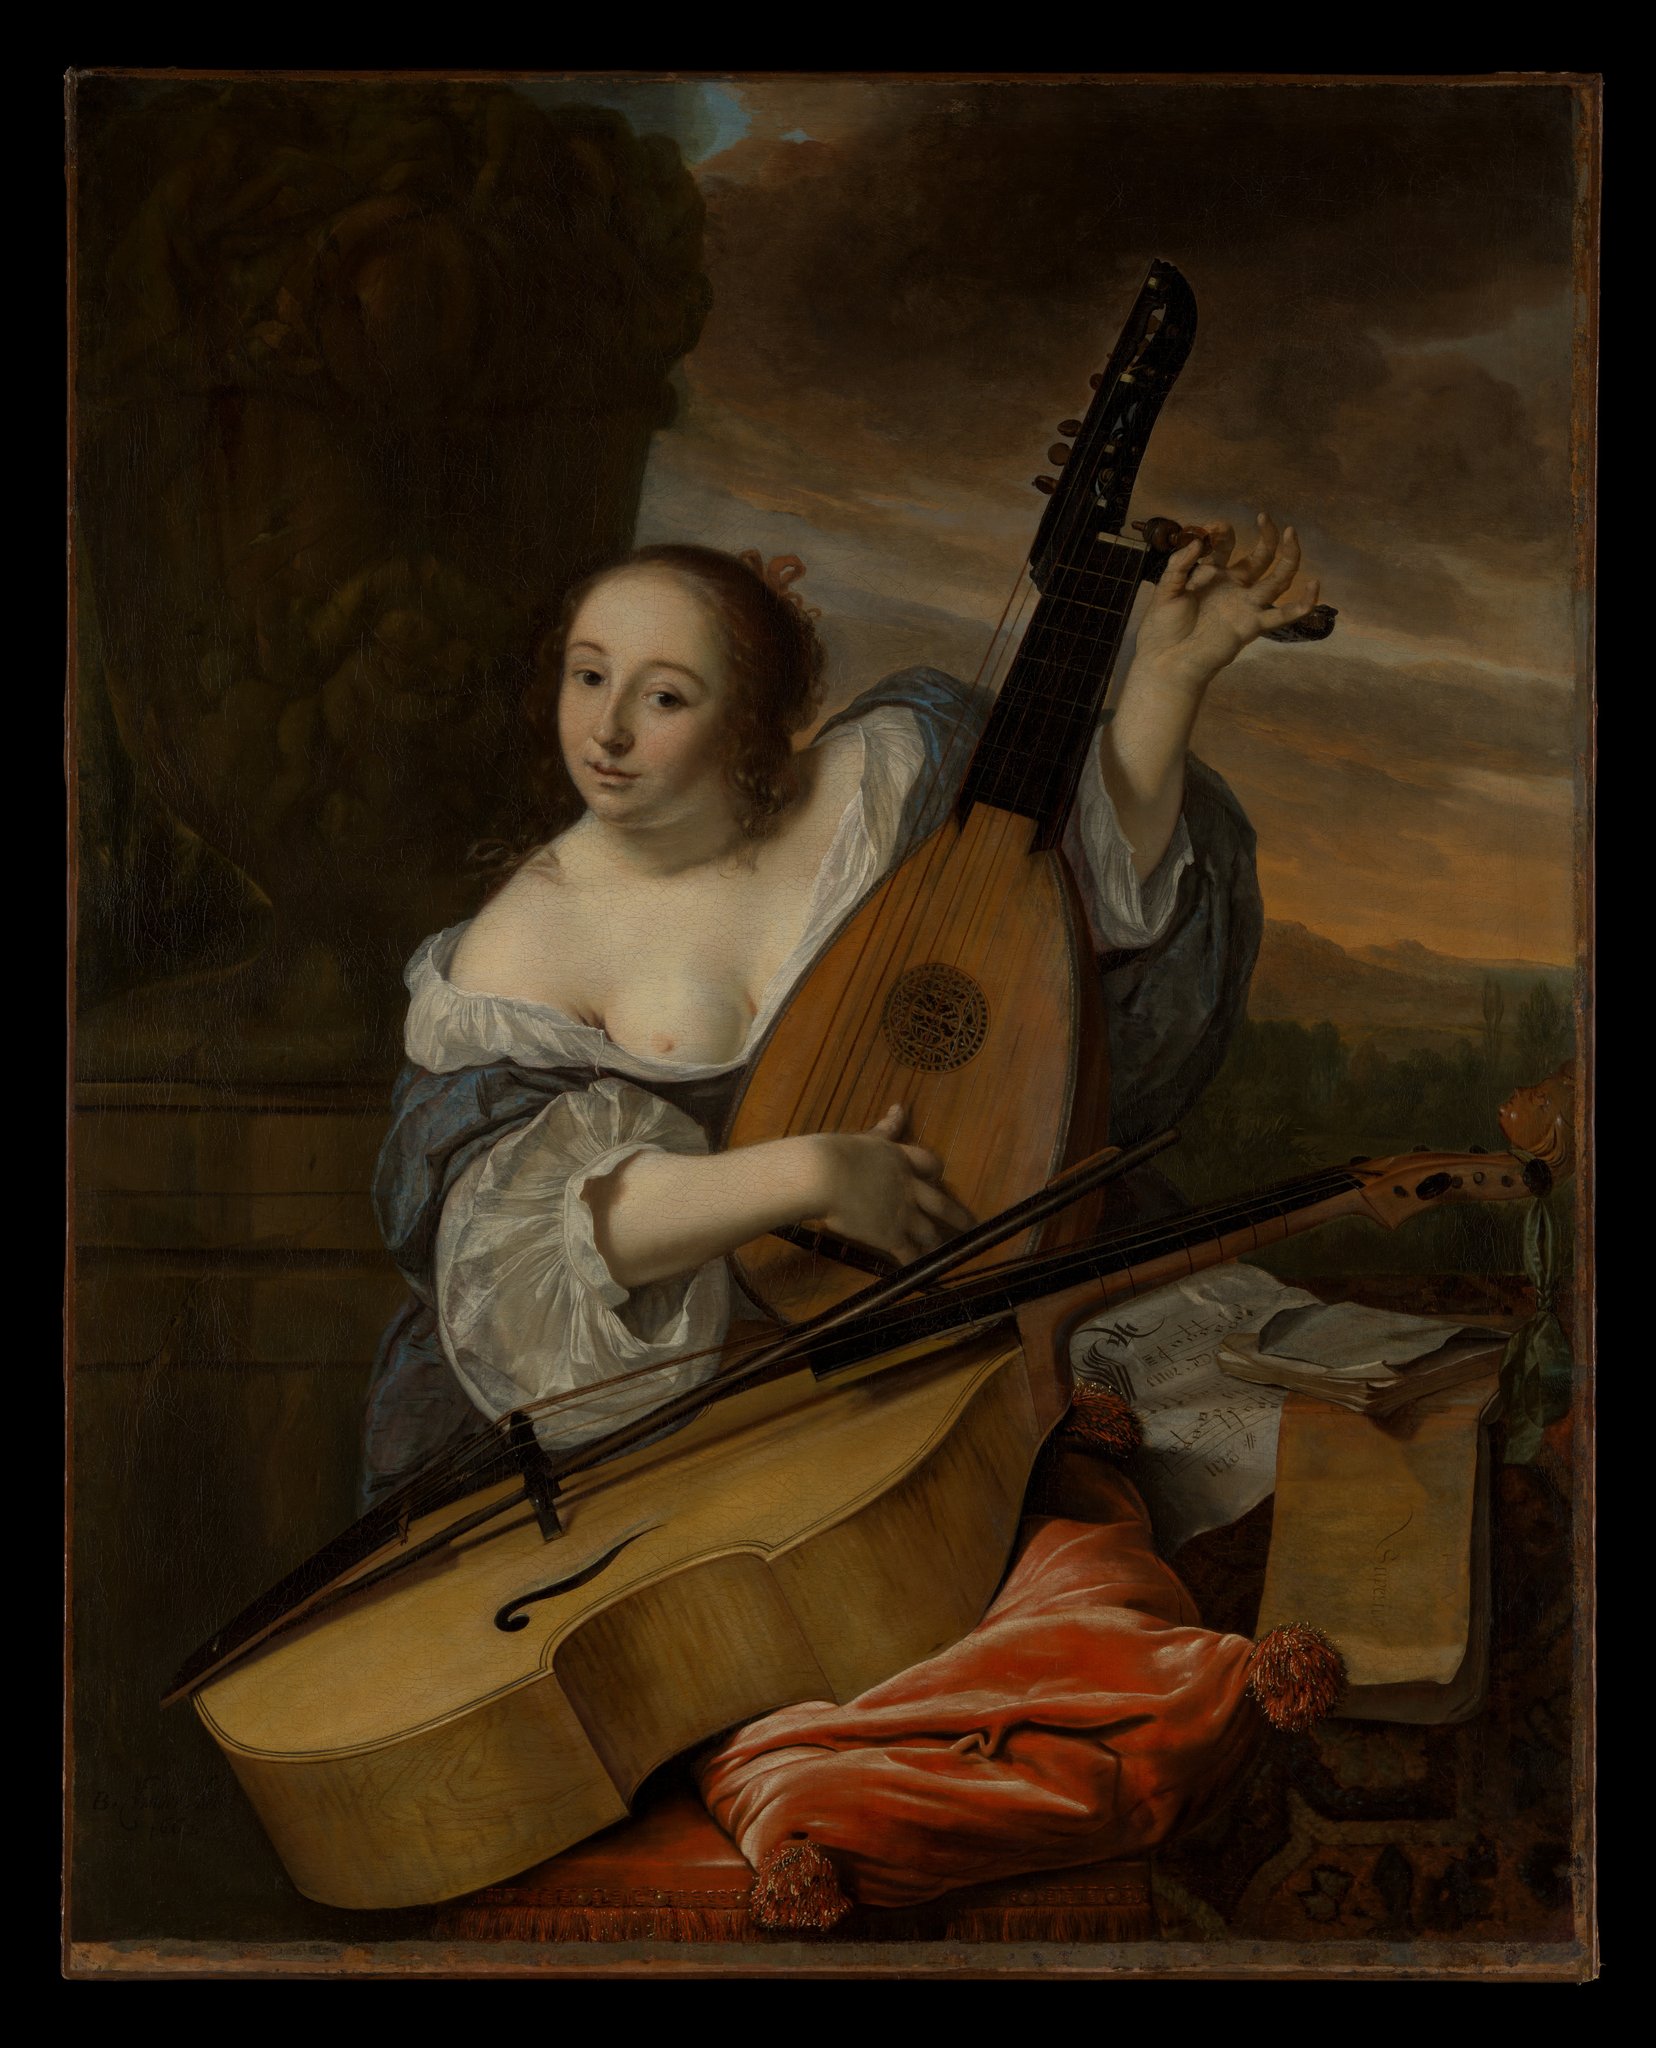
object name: painting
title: The Musician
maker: bartholomeus van der helst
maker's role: artist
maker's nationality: dutch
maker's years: 1612-1670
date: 1662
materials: canvas, oil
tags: musical instruments,women,music,lutes,musicians